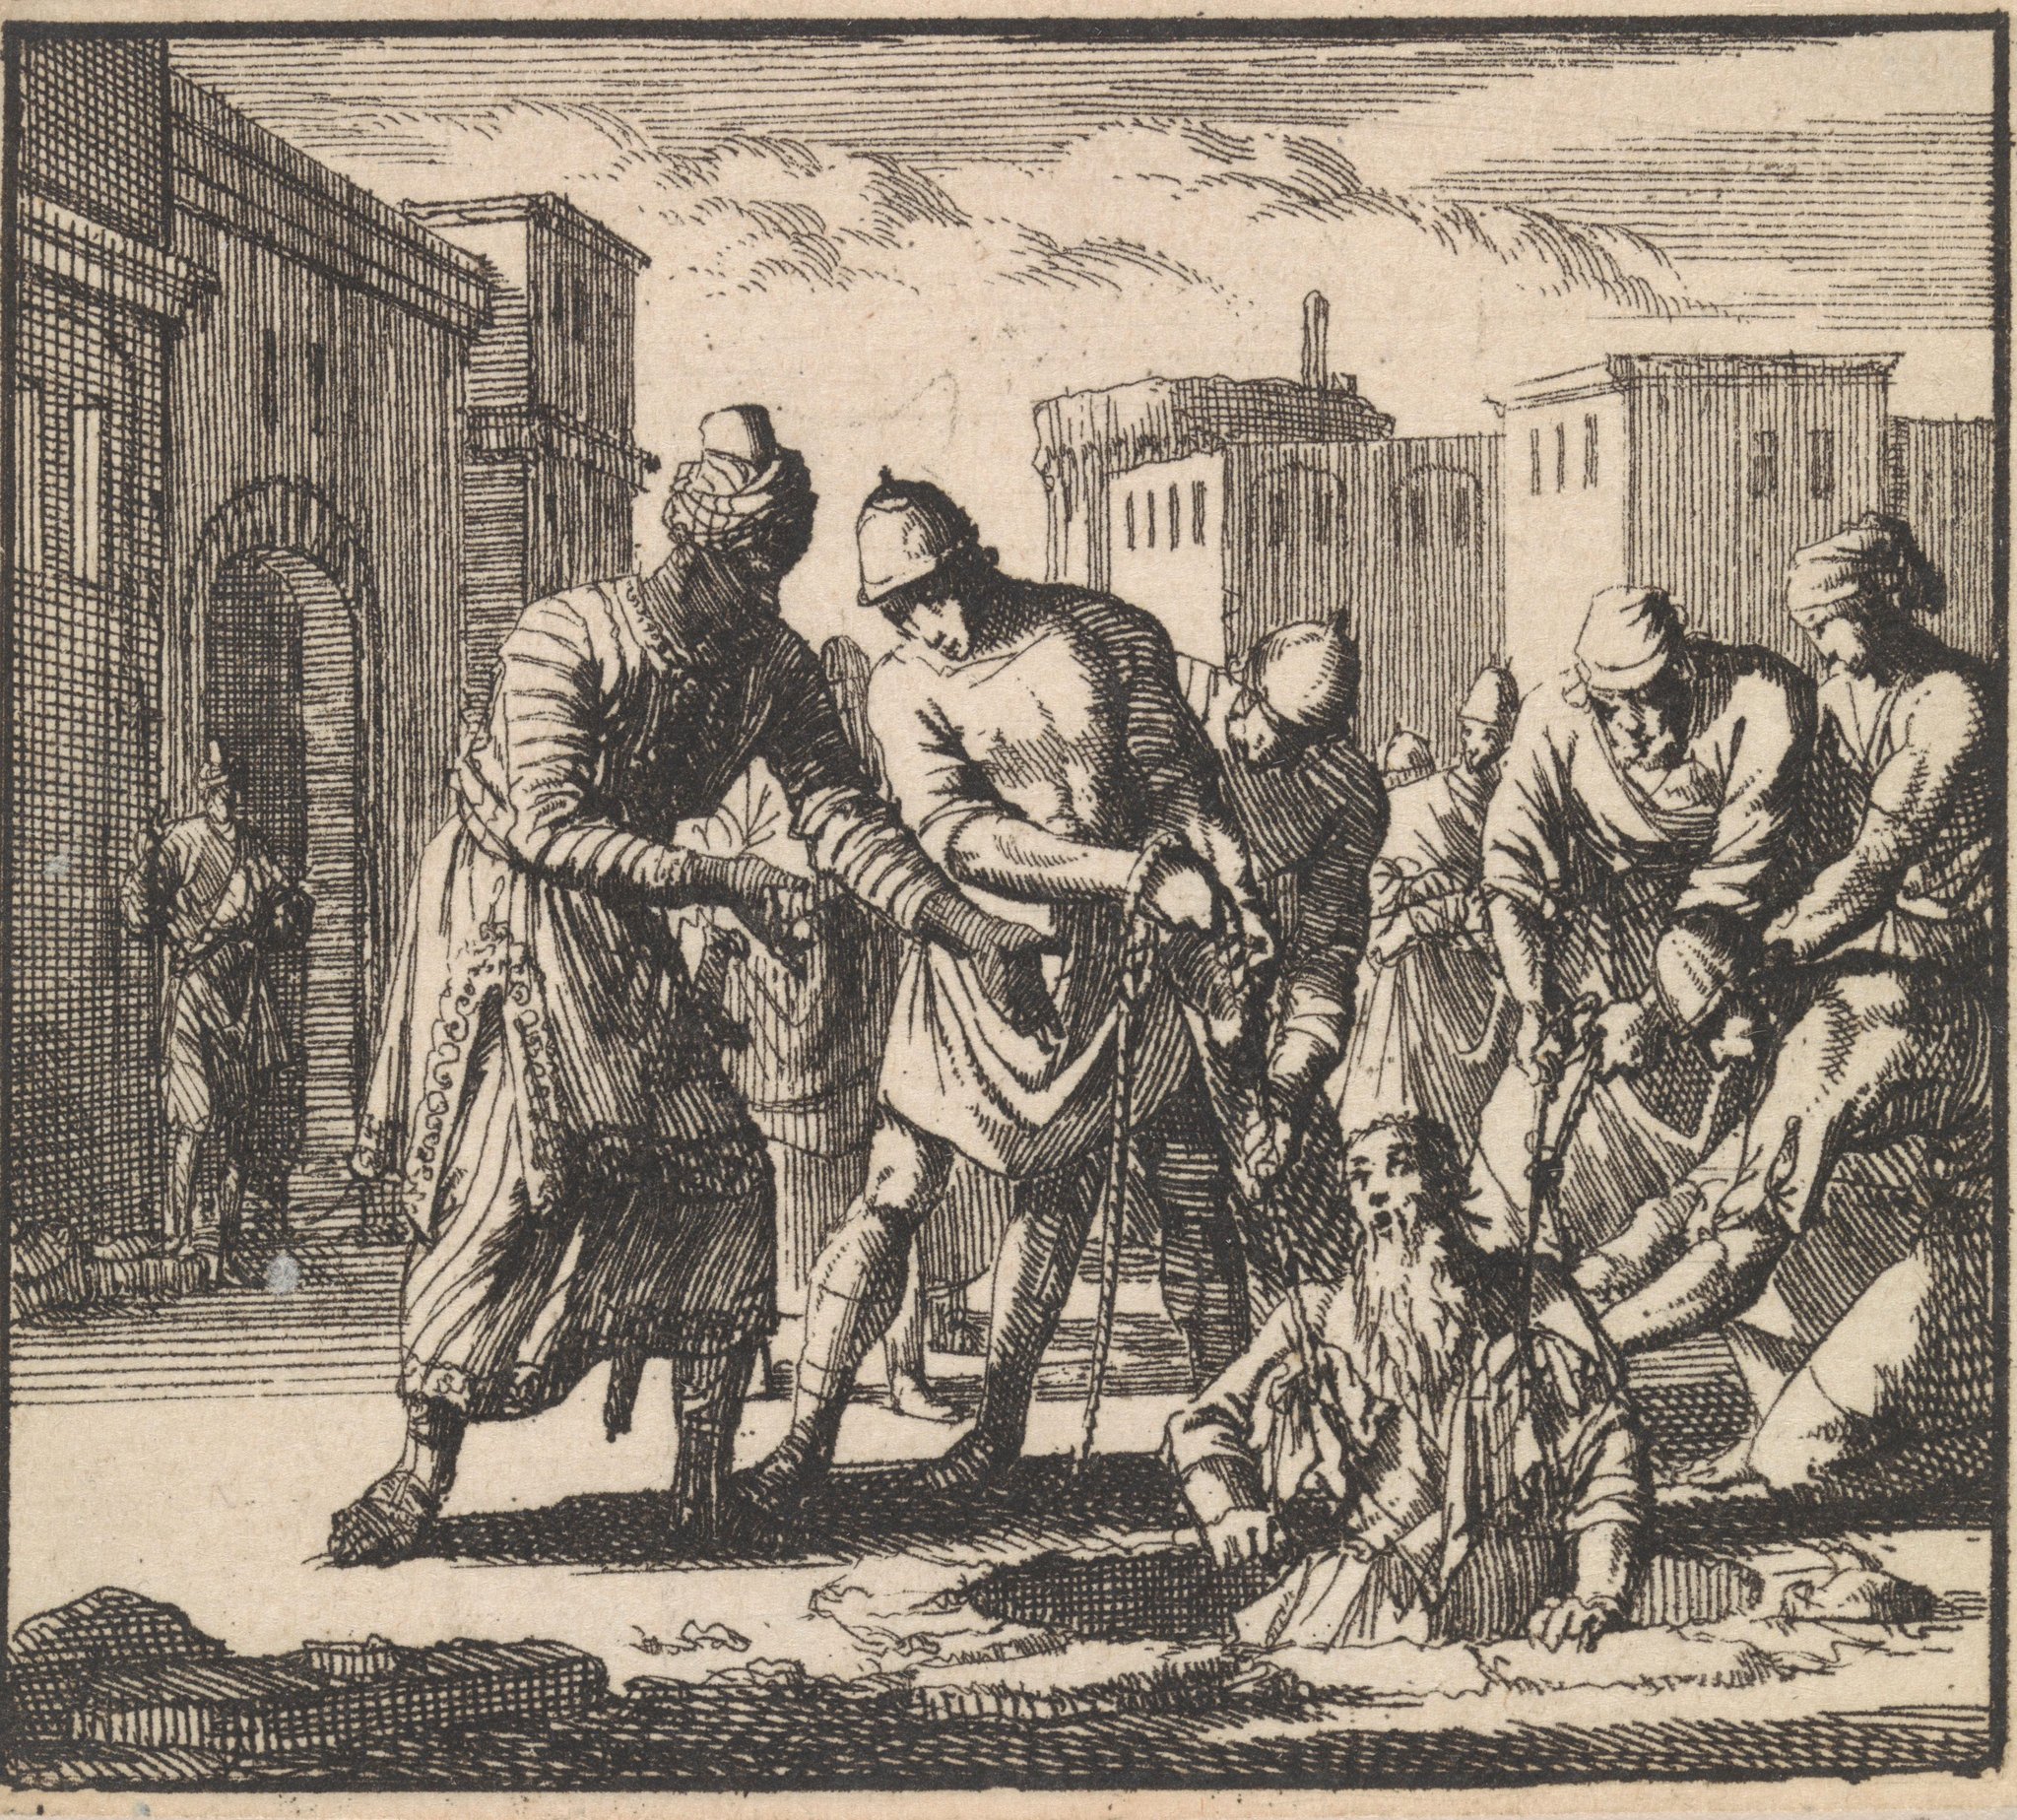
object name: print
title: Jeremia uit de kuil getrokken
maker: jan luyken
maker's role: draughtsman, print maker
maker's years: 1649-1712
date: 1698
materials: paper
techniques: etching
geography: amsterdam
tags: jeremiah's imprisonment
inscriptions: collector's mark: Lugt 2228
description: Proefdruk van illustratie uit: Josephus, Flavius. XX. boeken van de oude geschiedenissen der joden, 4 delen. Amsterdam: Barent Visscher, Willem de Coup, Willem van Lamsveld, Andries van Damme, 1698, dl. I.